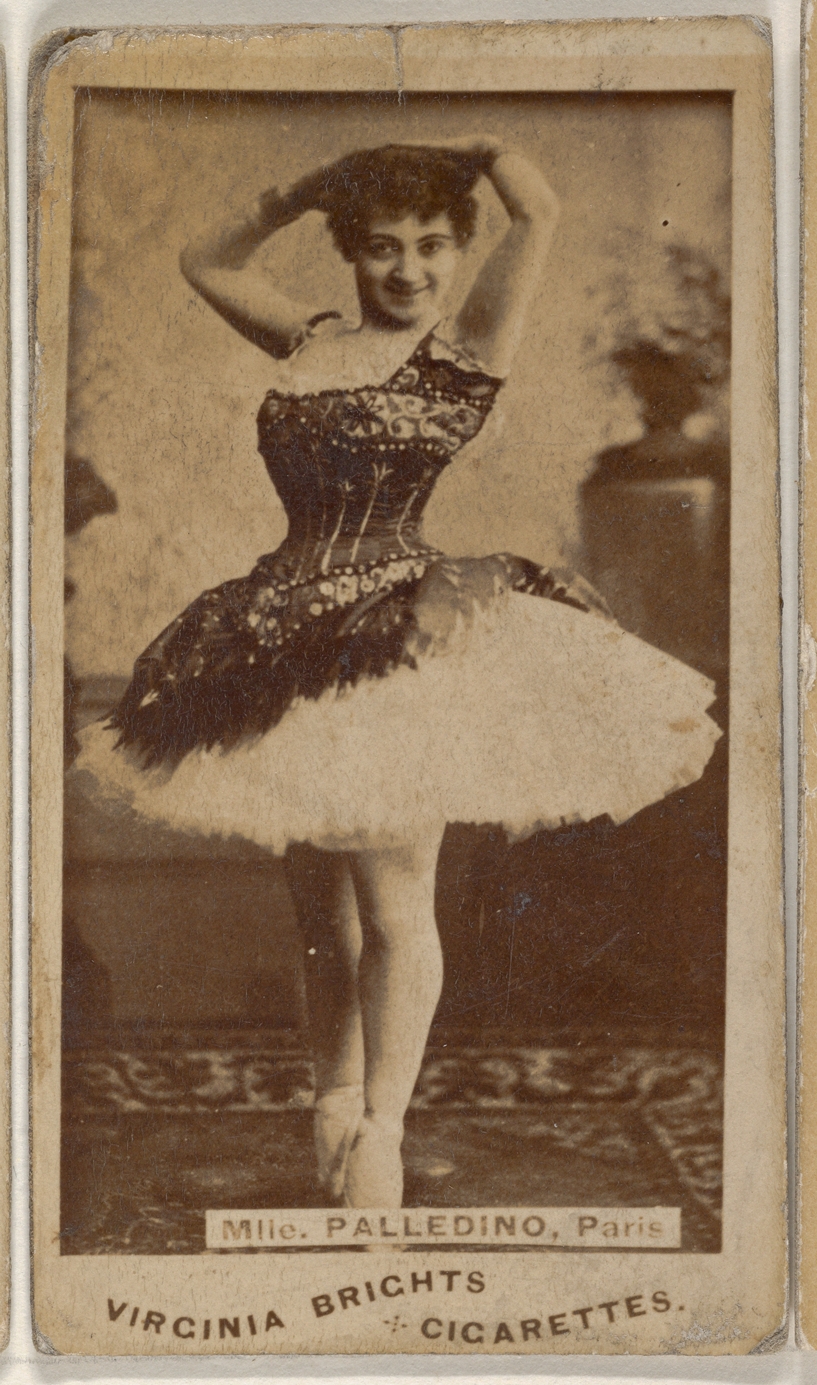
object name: photograph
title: Mlle. Palledino, Paris, from the Actors and Actresses series (N45, Type 1) for Virginia Brights Cigarettes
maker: allen & ginter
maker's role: publisher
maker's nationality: american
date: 1888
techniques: albumen silver print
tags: portraits,women,actresses